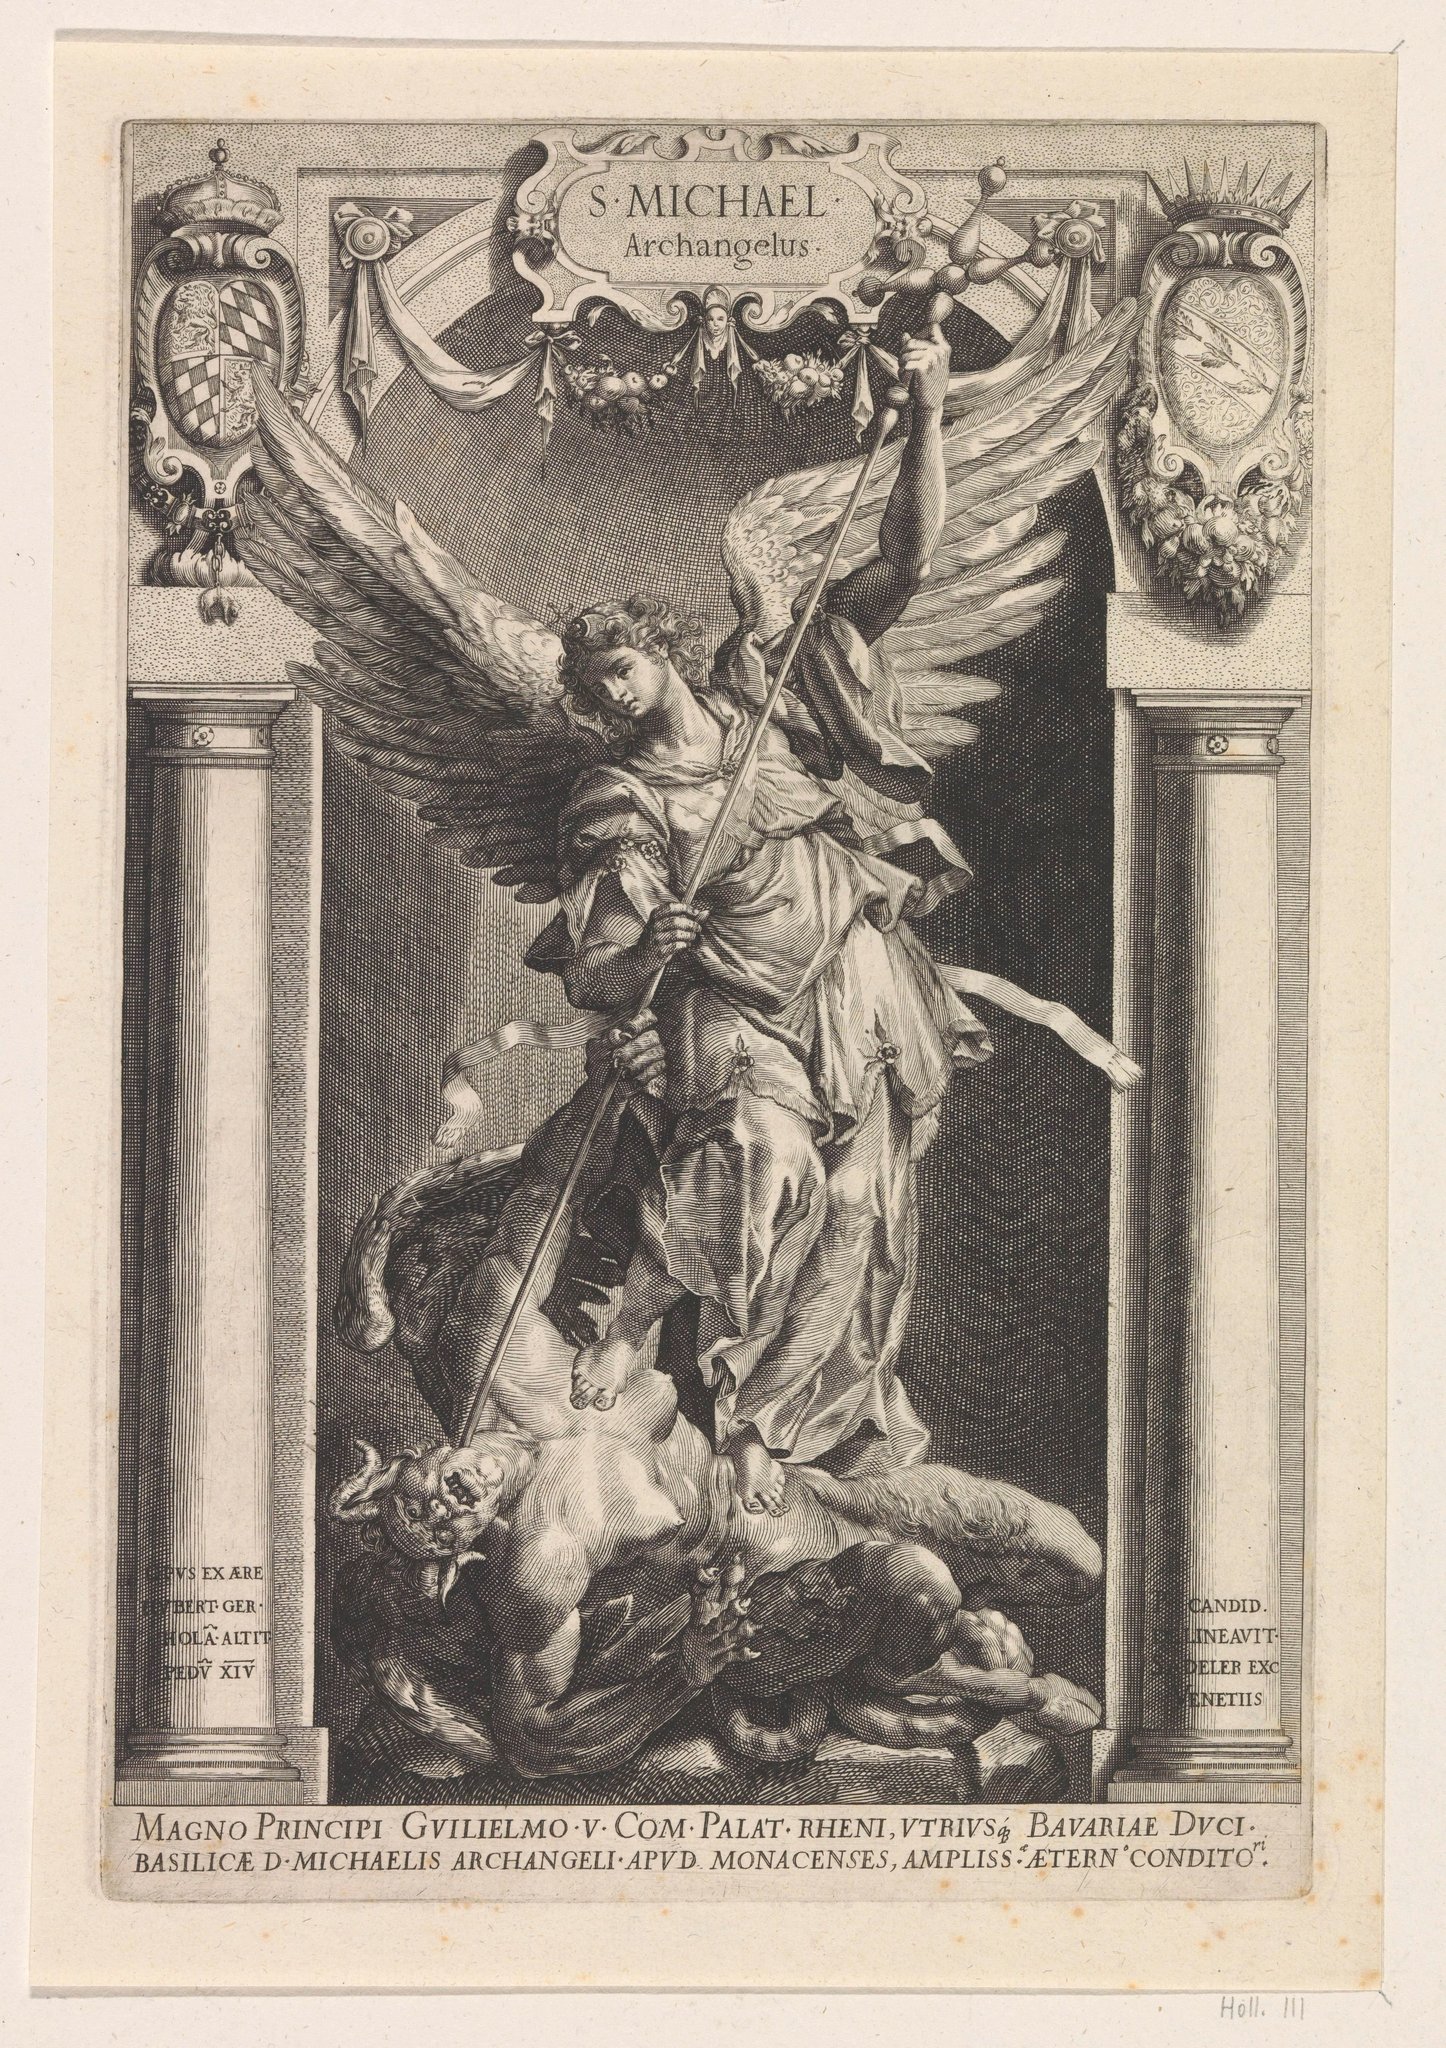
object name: print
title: S. Michael Archangelus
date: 1595-1604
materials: paper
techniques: engraving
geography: munich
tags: the archangel michael fighting the dragon (devil, satan), piece of sculpture, reproduction of a piece of sculpture, armorial bearing, heraldry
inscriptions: collector's mark: Lugt 240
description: De aartsengel Michaël vertrapt een duivel en doorboort zijn keel met een lans.